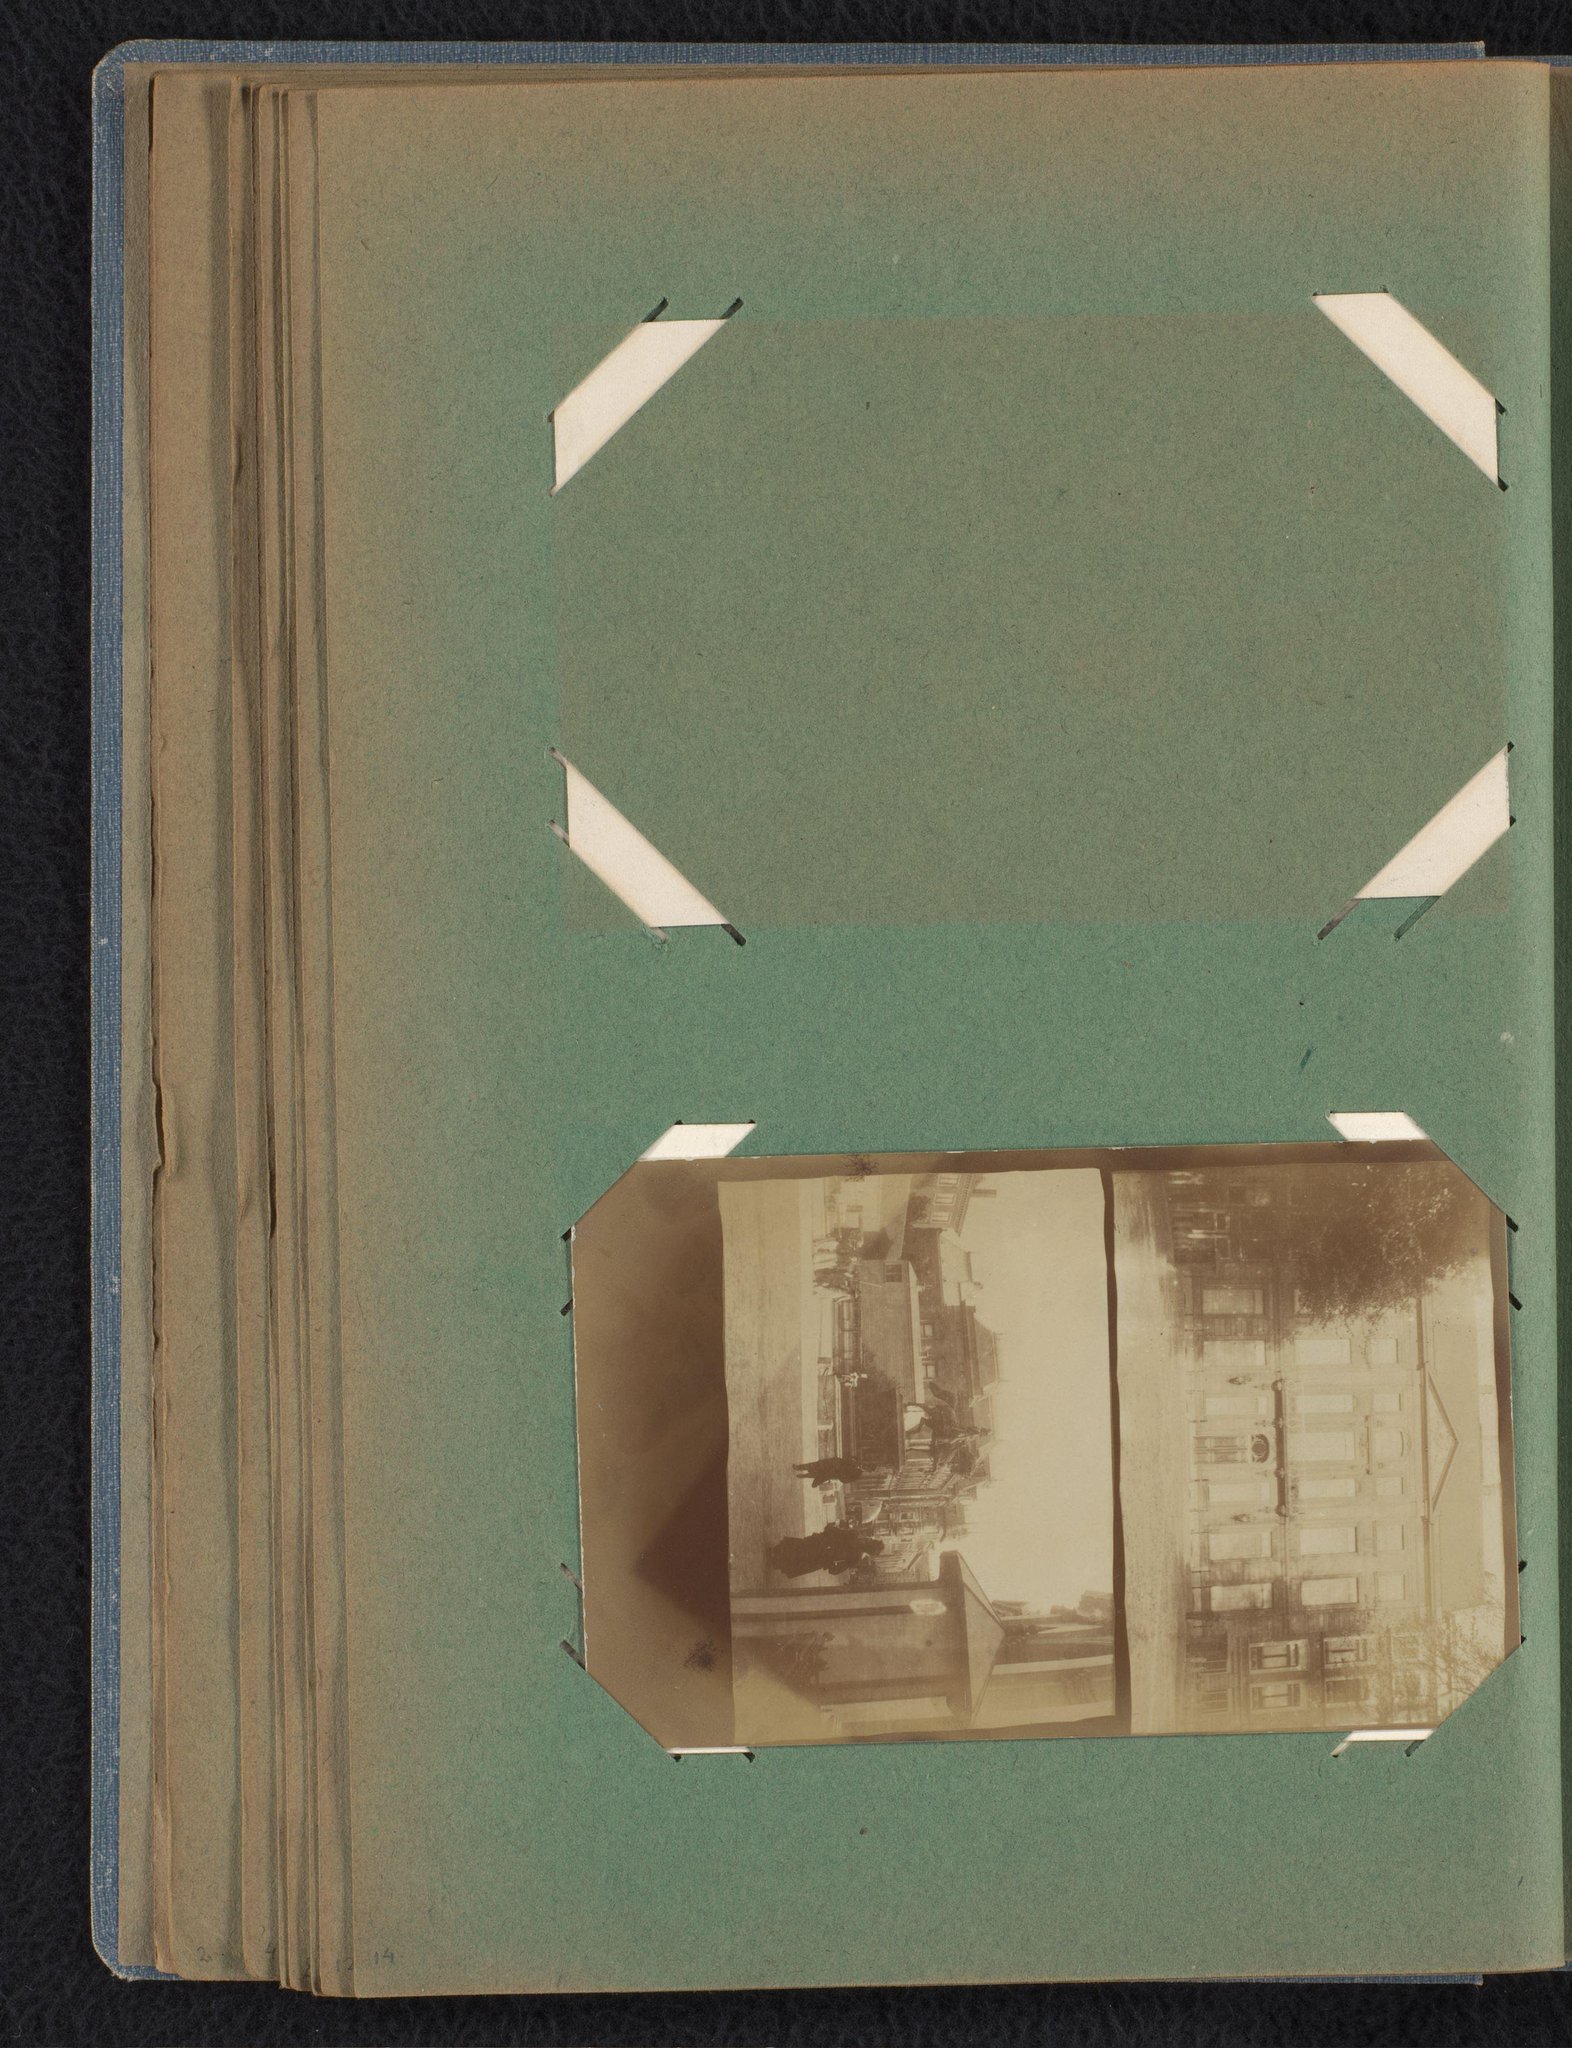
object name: ansichtkaart, prentbriefkaart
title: Prentbriefkaart met twee foto's van Paleis Lange Voorhout en Paleis Noordeinde, Den Haag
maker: Anonymous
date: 1905-1915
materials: paper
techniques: gelatin silver print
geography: the hague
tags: palace